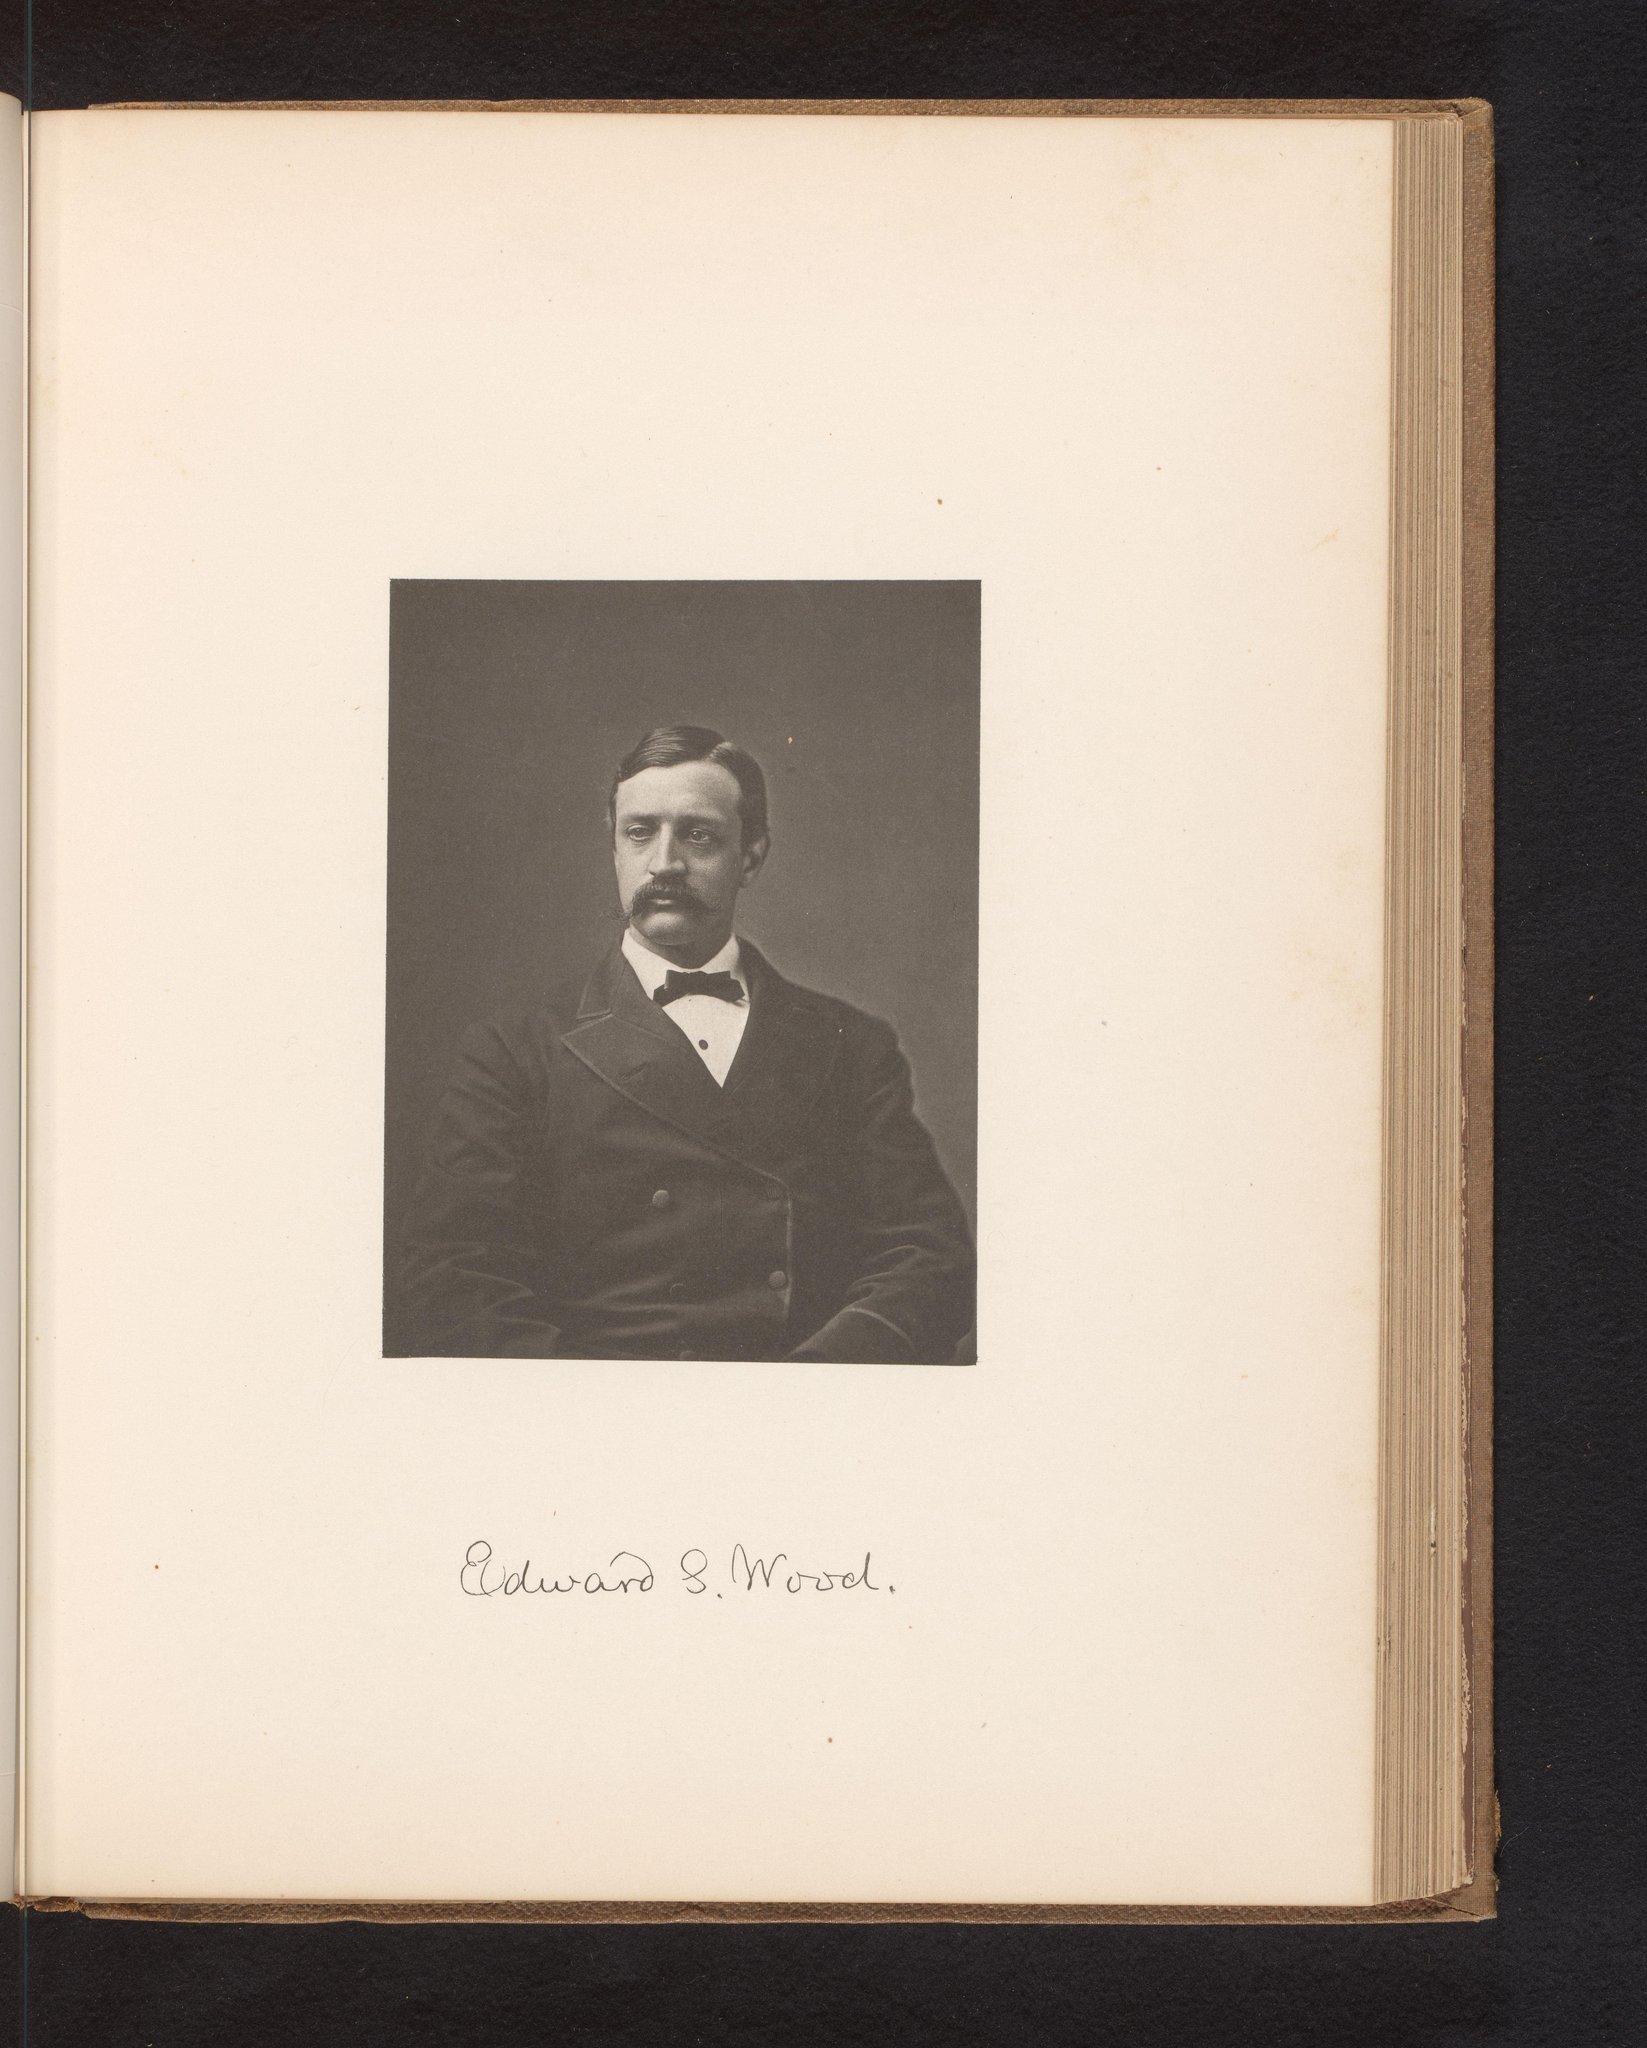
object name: page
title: Portret van Edward Stickney Wood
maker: Anonymous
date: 1870-1875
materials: paper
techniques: photograph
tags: historical persons, physician, doctor, professor